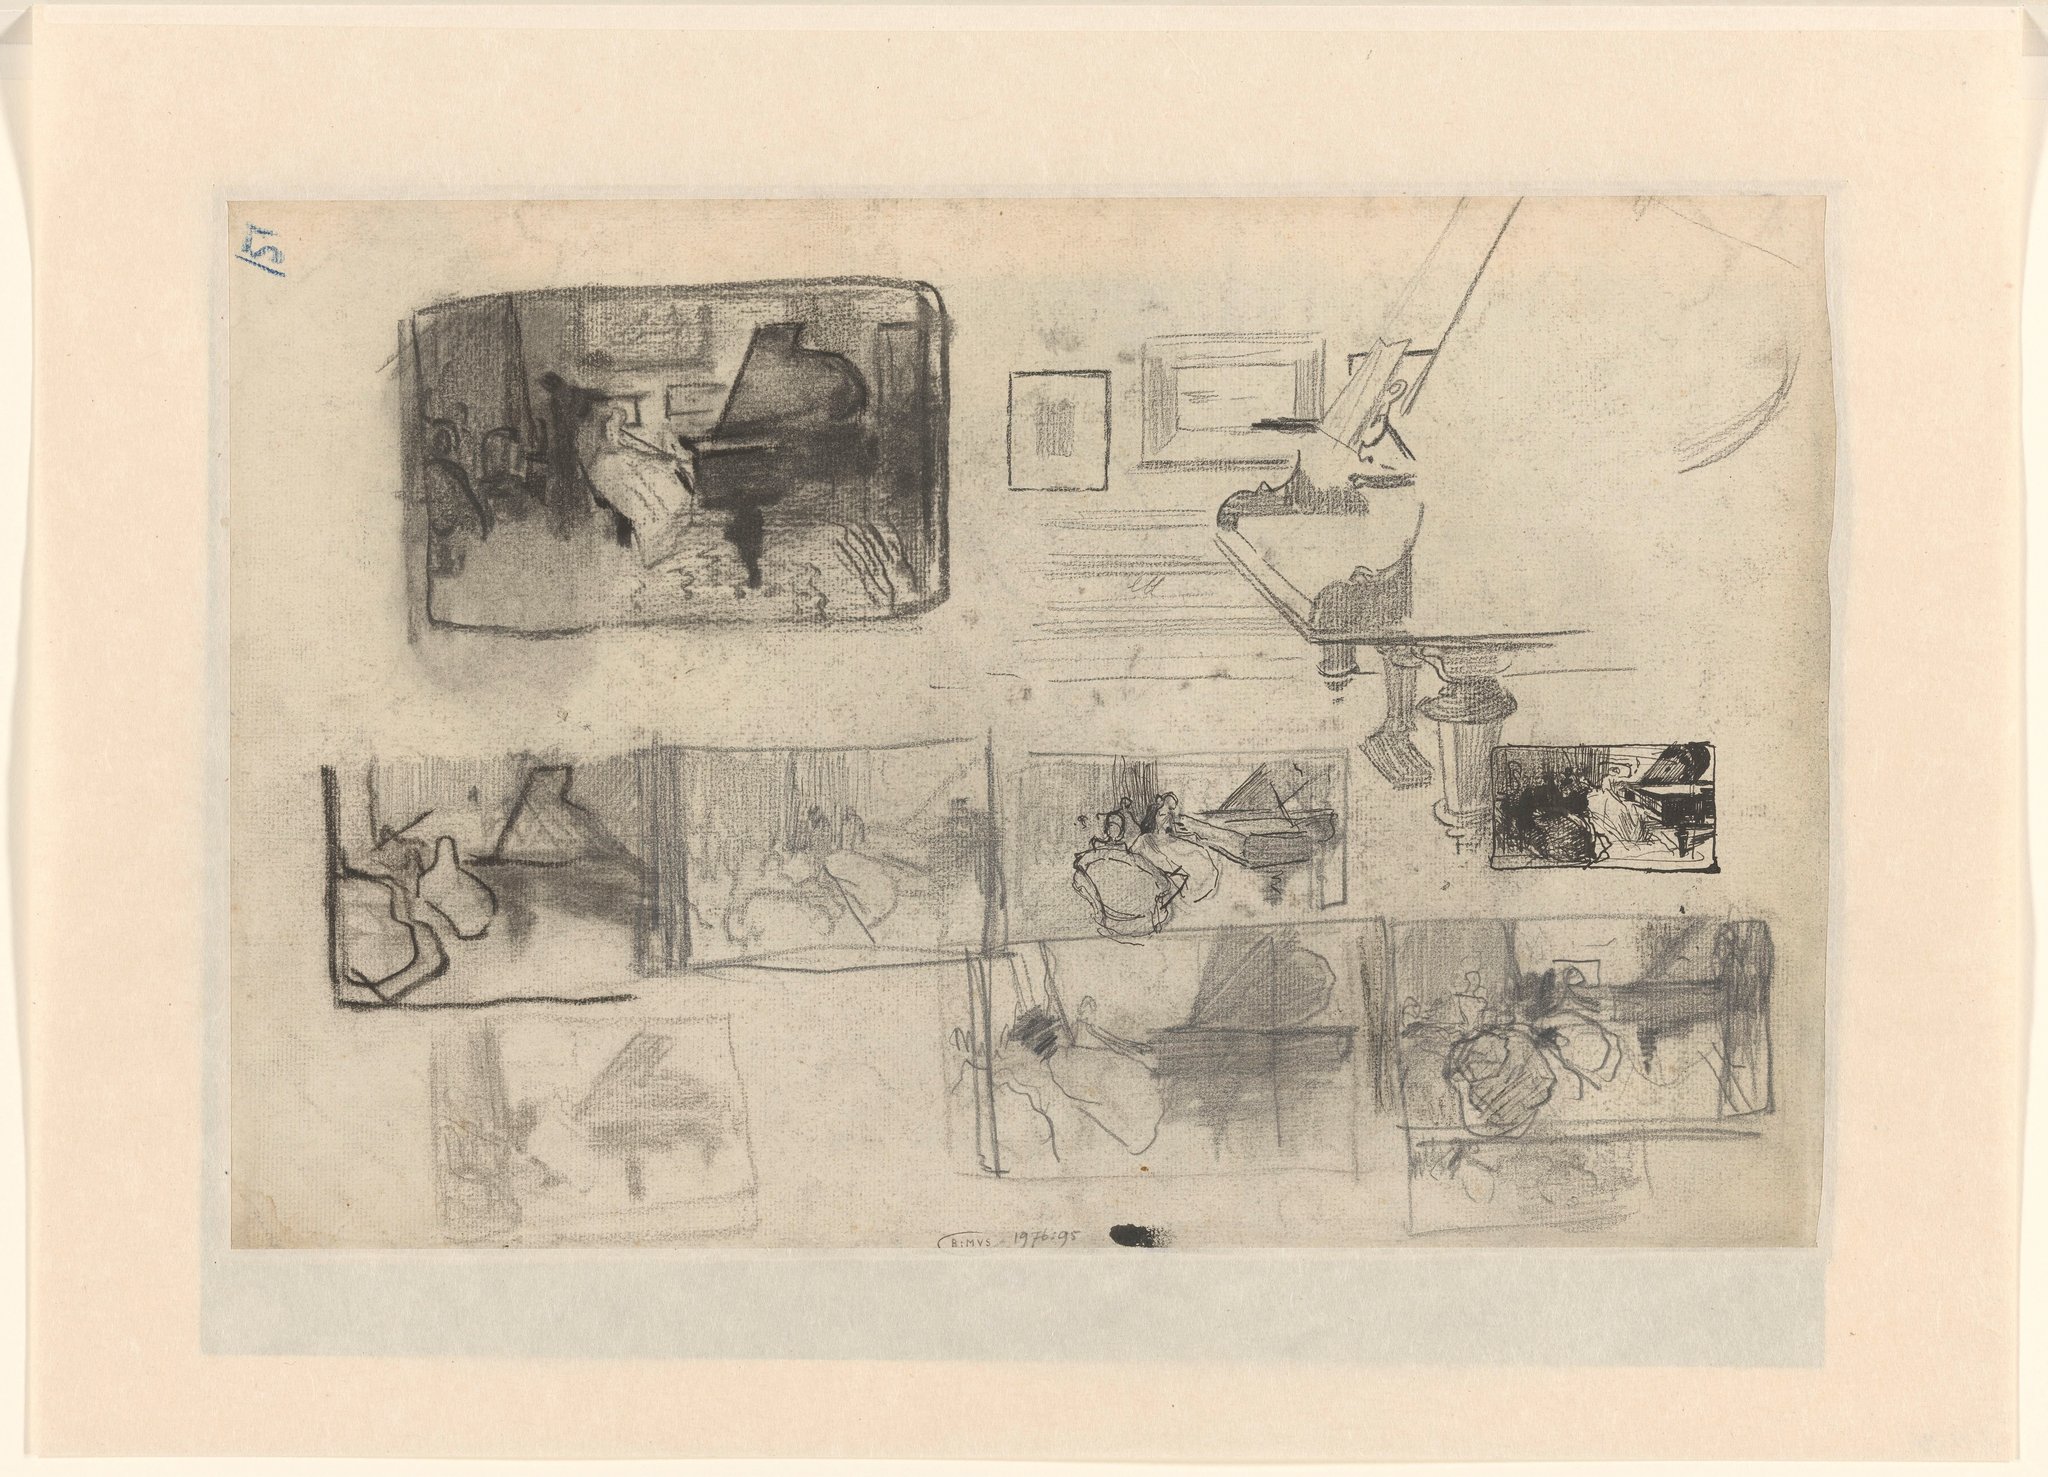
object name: drawing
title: Compositie studies van een pianoconcert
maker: a.a.l. de grammont-hubrecht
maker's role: draughtsman, painter, print maker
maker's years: 1855-1913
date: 1865-1913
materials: chalk, ink, paper, pencil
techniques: pen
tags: grand piano, more than one musician with instrument